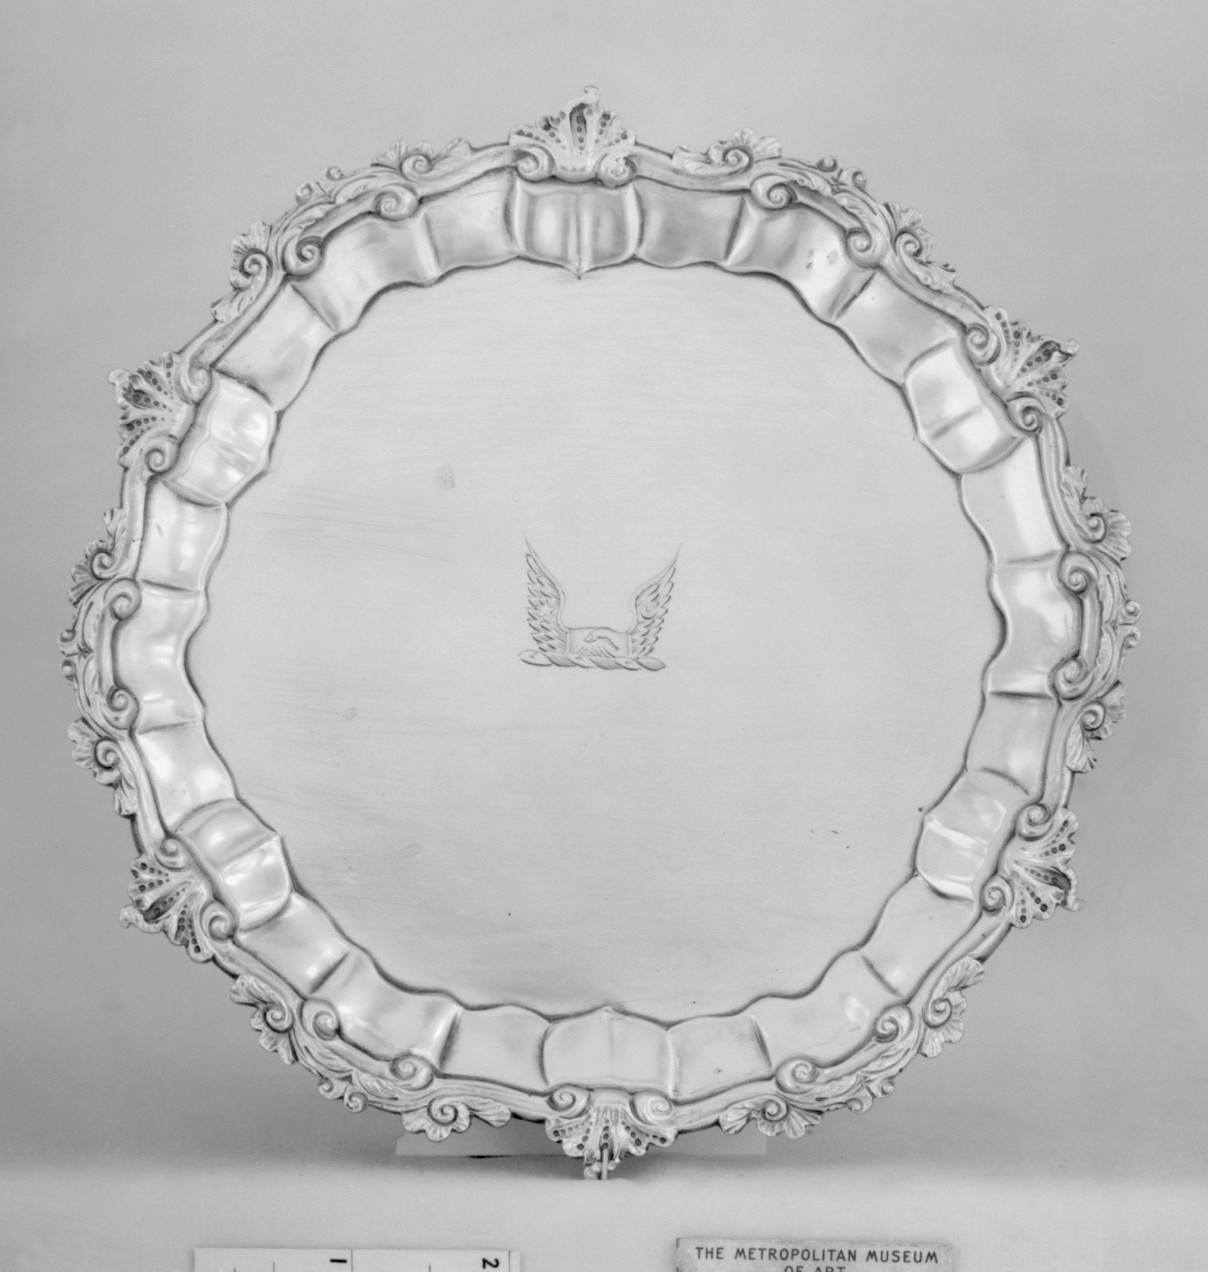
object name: salver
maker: william reynolds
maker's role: maker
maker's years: 1725-1825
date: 1770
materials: silver